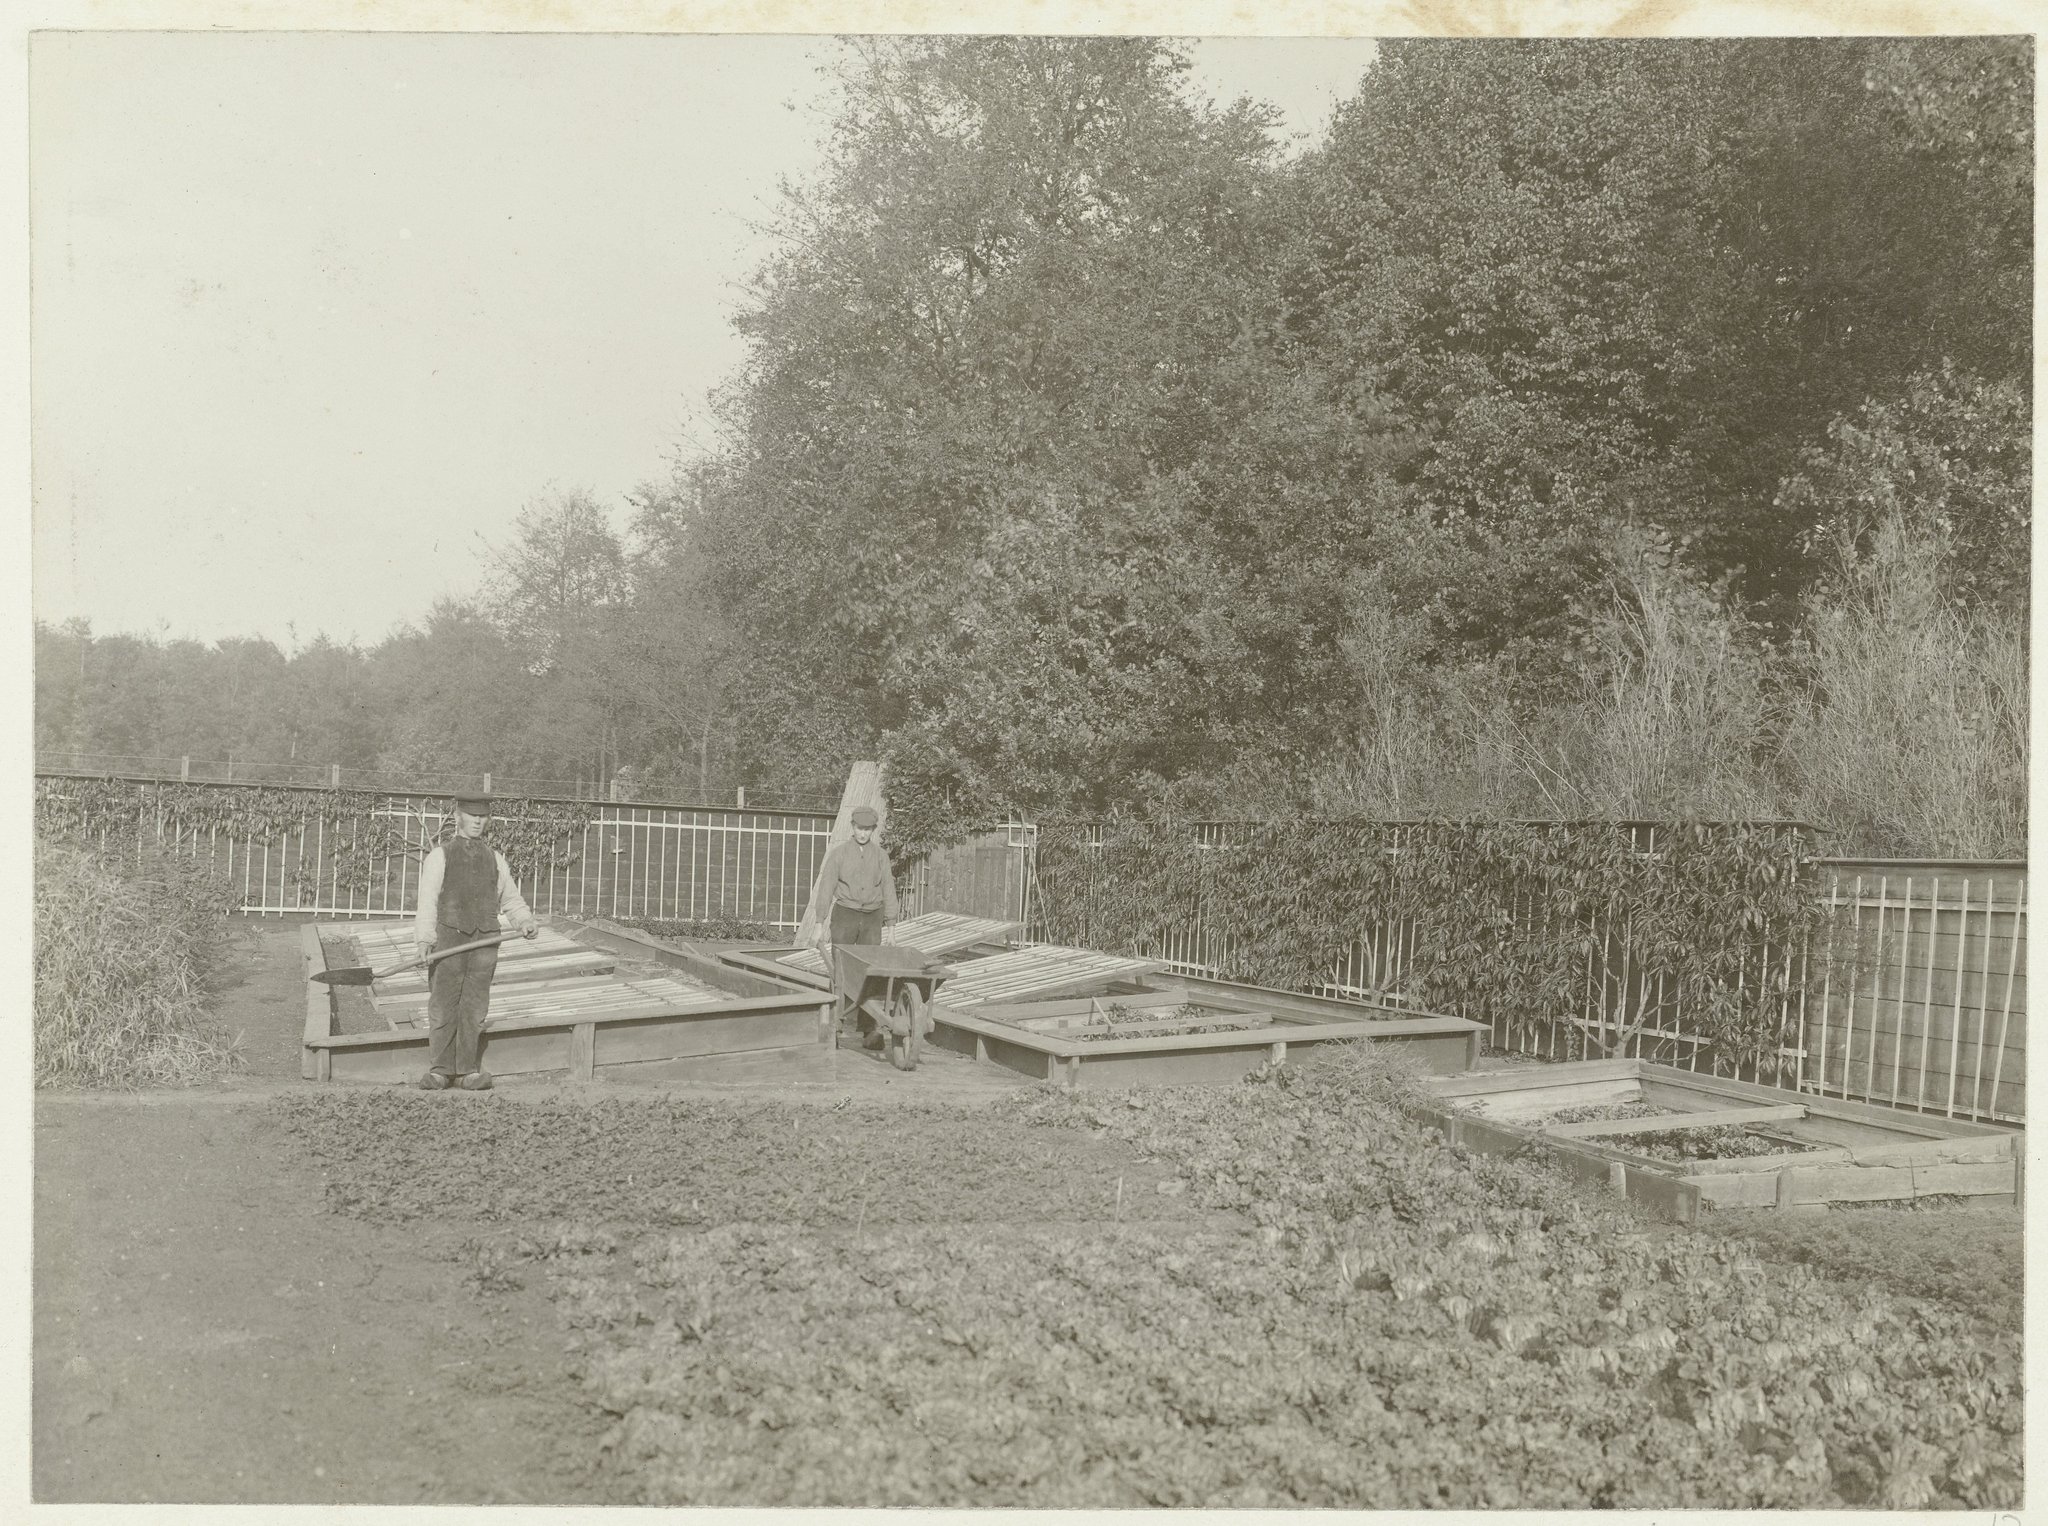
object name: photograph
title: Tweetuinmannen (?) aan het werk in de moestuin van landhuis De Wildbaan, Driebergen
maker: henry pauw van wieldrecht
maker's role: fotograaf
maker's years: 1863-1912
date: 1903-1907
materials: paper, photographic support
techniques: photography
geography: netherlands